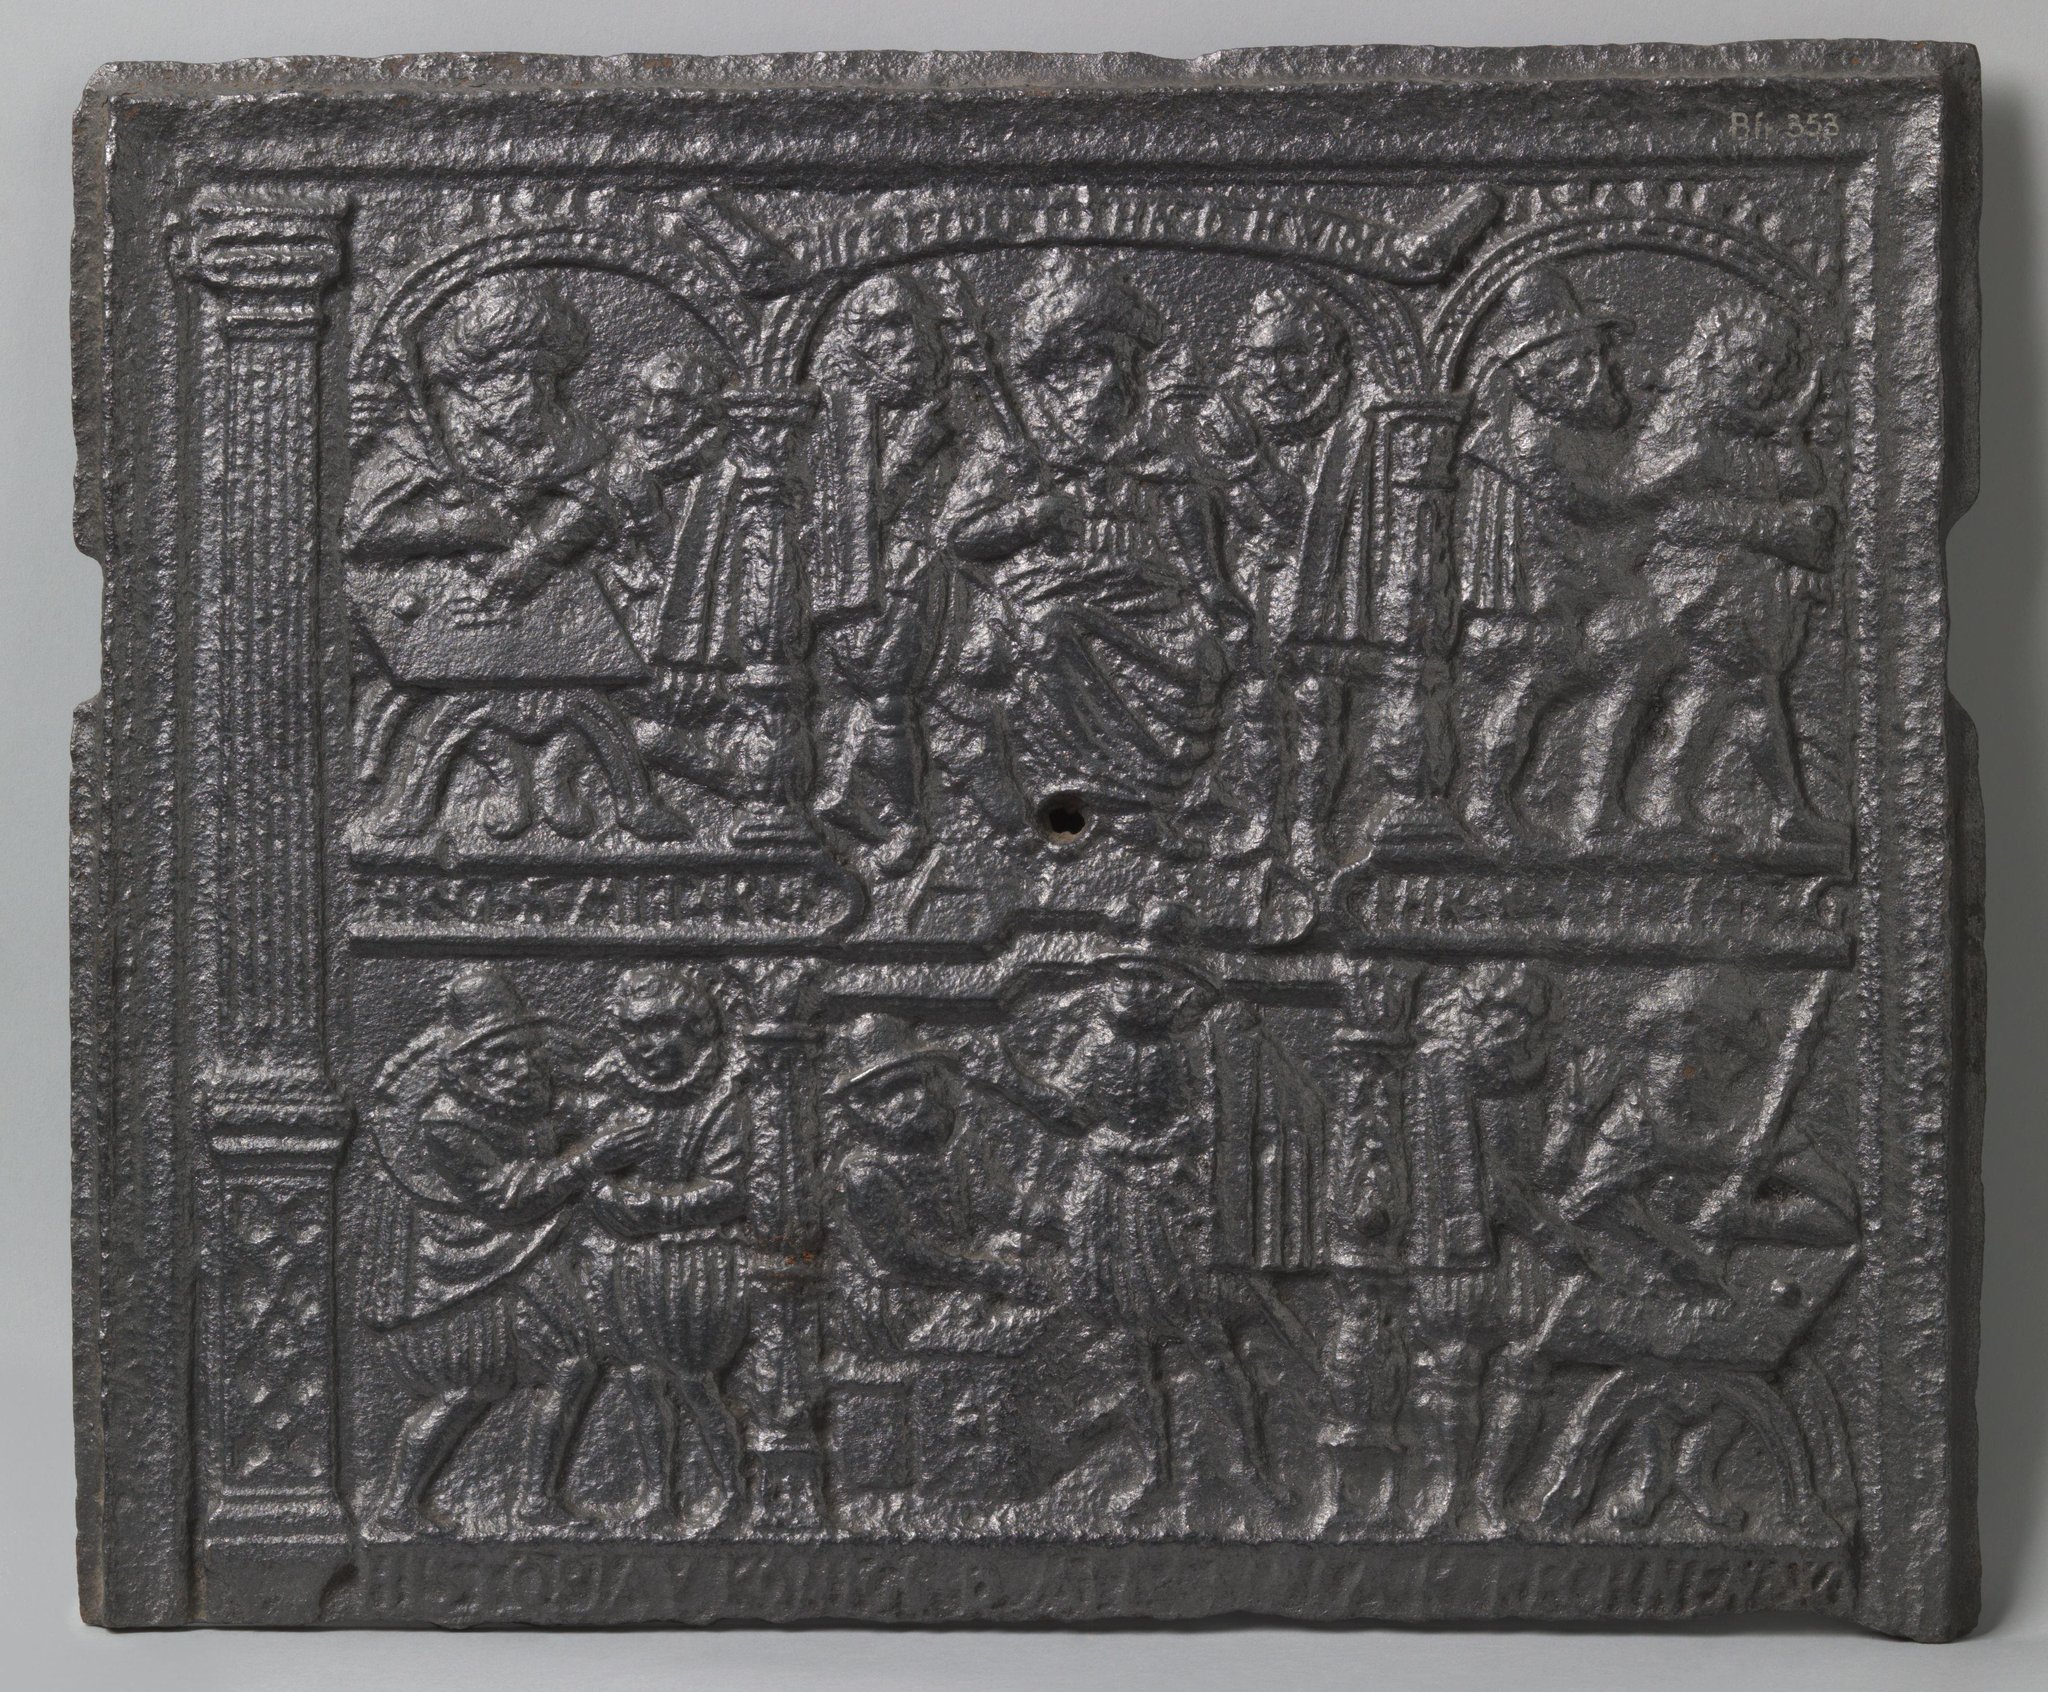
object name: fragment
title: Kachelplaat met zes taferelen uit het leven van een koning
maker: Anonymous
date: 1550-1600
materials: iron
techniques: casting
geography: germany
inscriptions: inscription, inscription: ‘HISTORIA KONIGS [...] RECHNEN [...]’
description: Kachelplaat van gietijzer, verdeeld in twee zones. In de bovenste zone is een geschiedenis in zes taferelen, gescheiden van elkaar door zuilen en in twee zones. In de vlakken links onder en rechts boven zijn telkens twee staande figuren weergegeven. In de vakken links boven en rechts onder zit telkens een man aan tafel en staat een man ervoor. Het middentafereel bovenaan toont een man op een ruime zetel met twee mannen naast hem. De onderste zone is verloren gegaan. Tussen beide zones is een tekstband aangebracht.